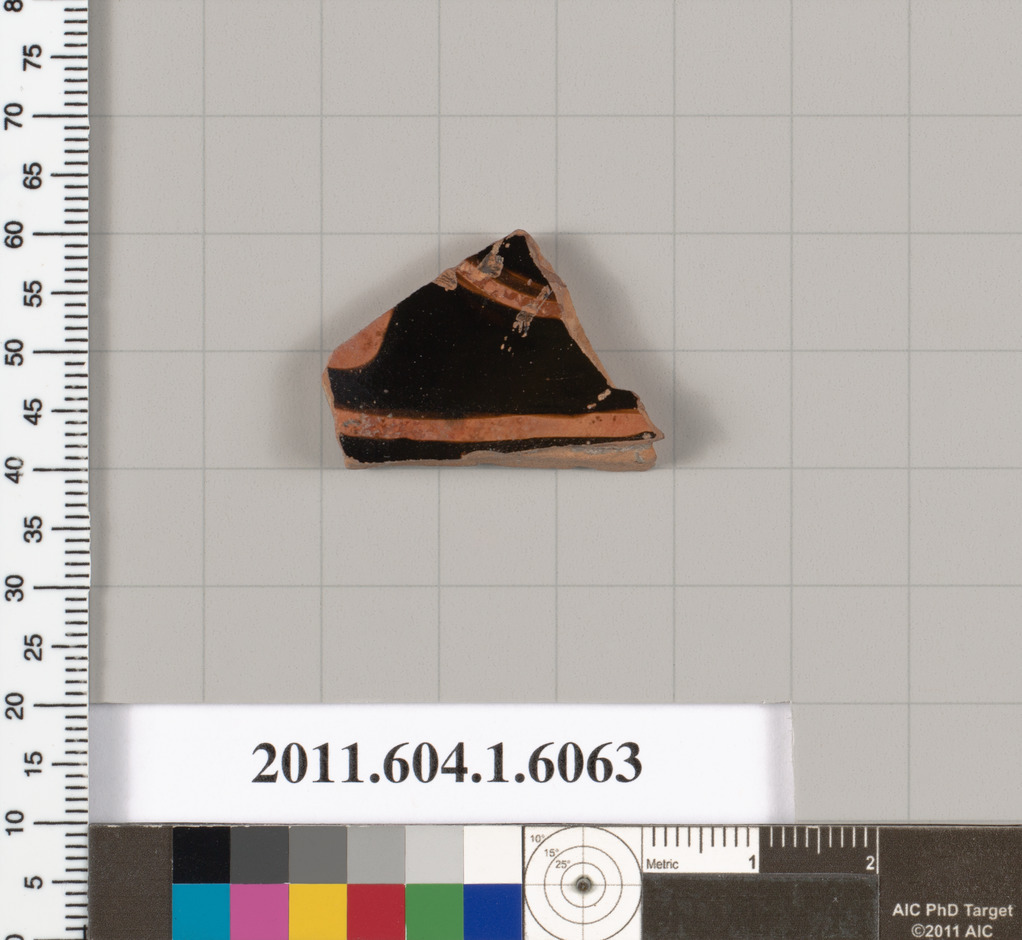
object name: kylix fragment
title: Terracotta fragment of a kylix (drinking cup)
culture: greek, attic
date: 510-500 BCE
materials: terracotta